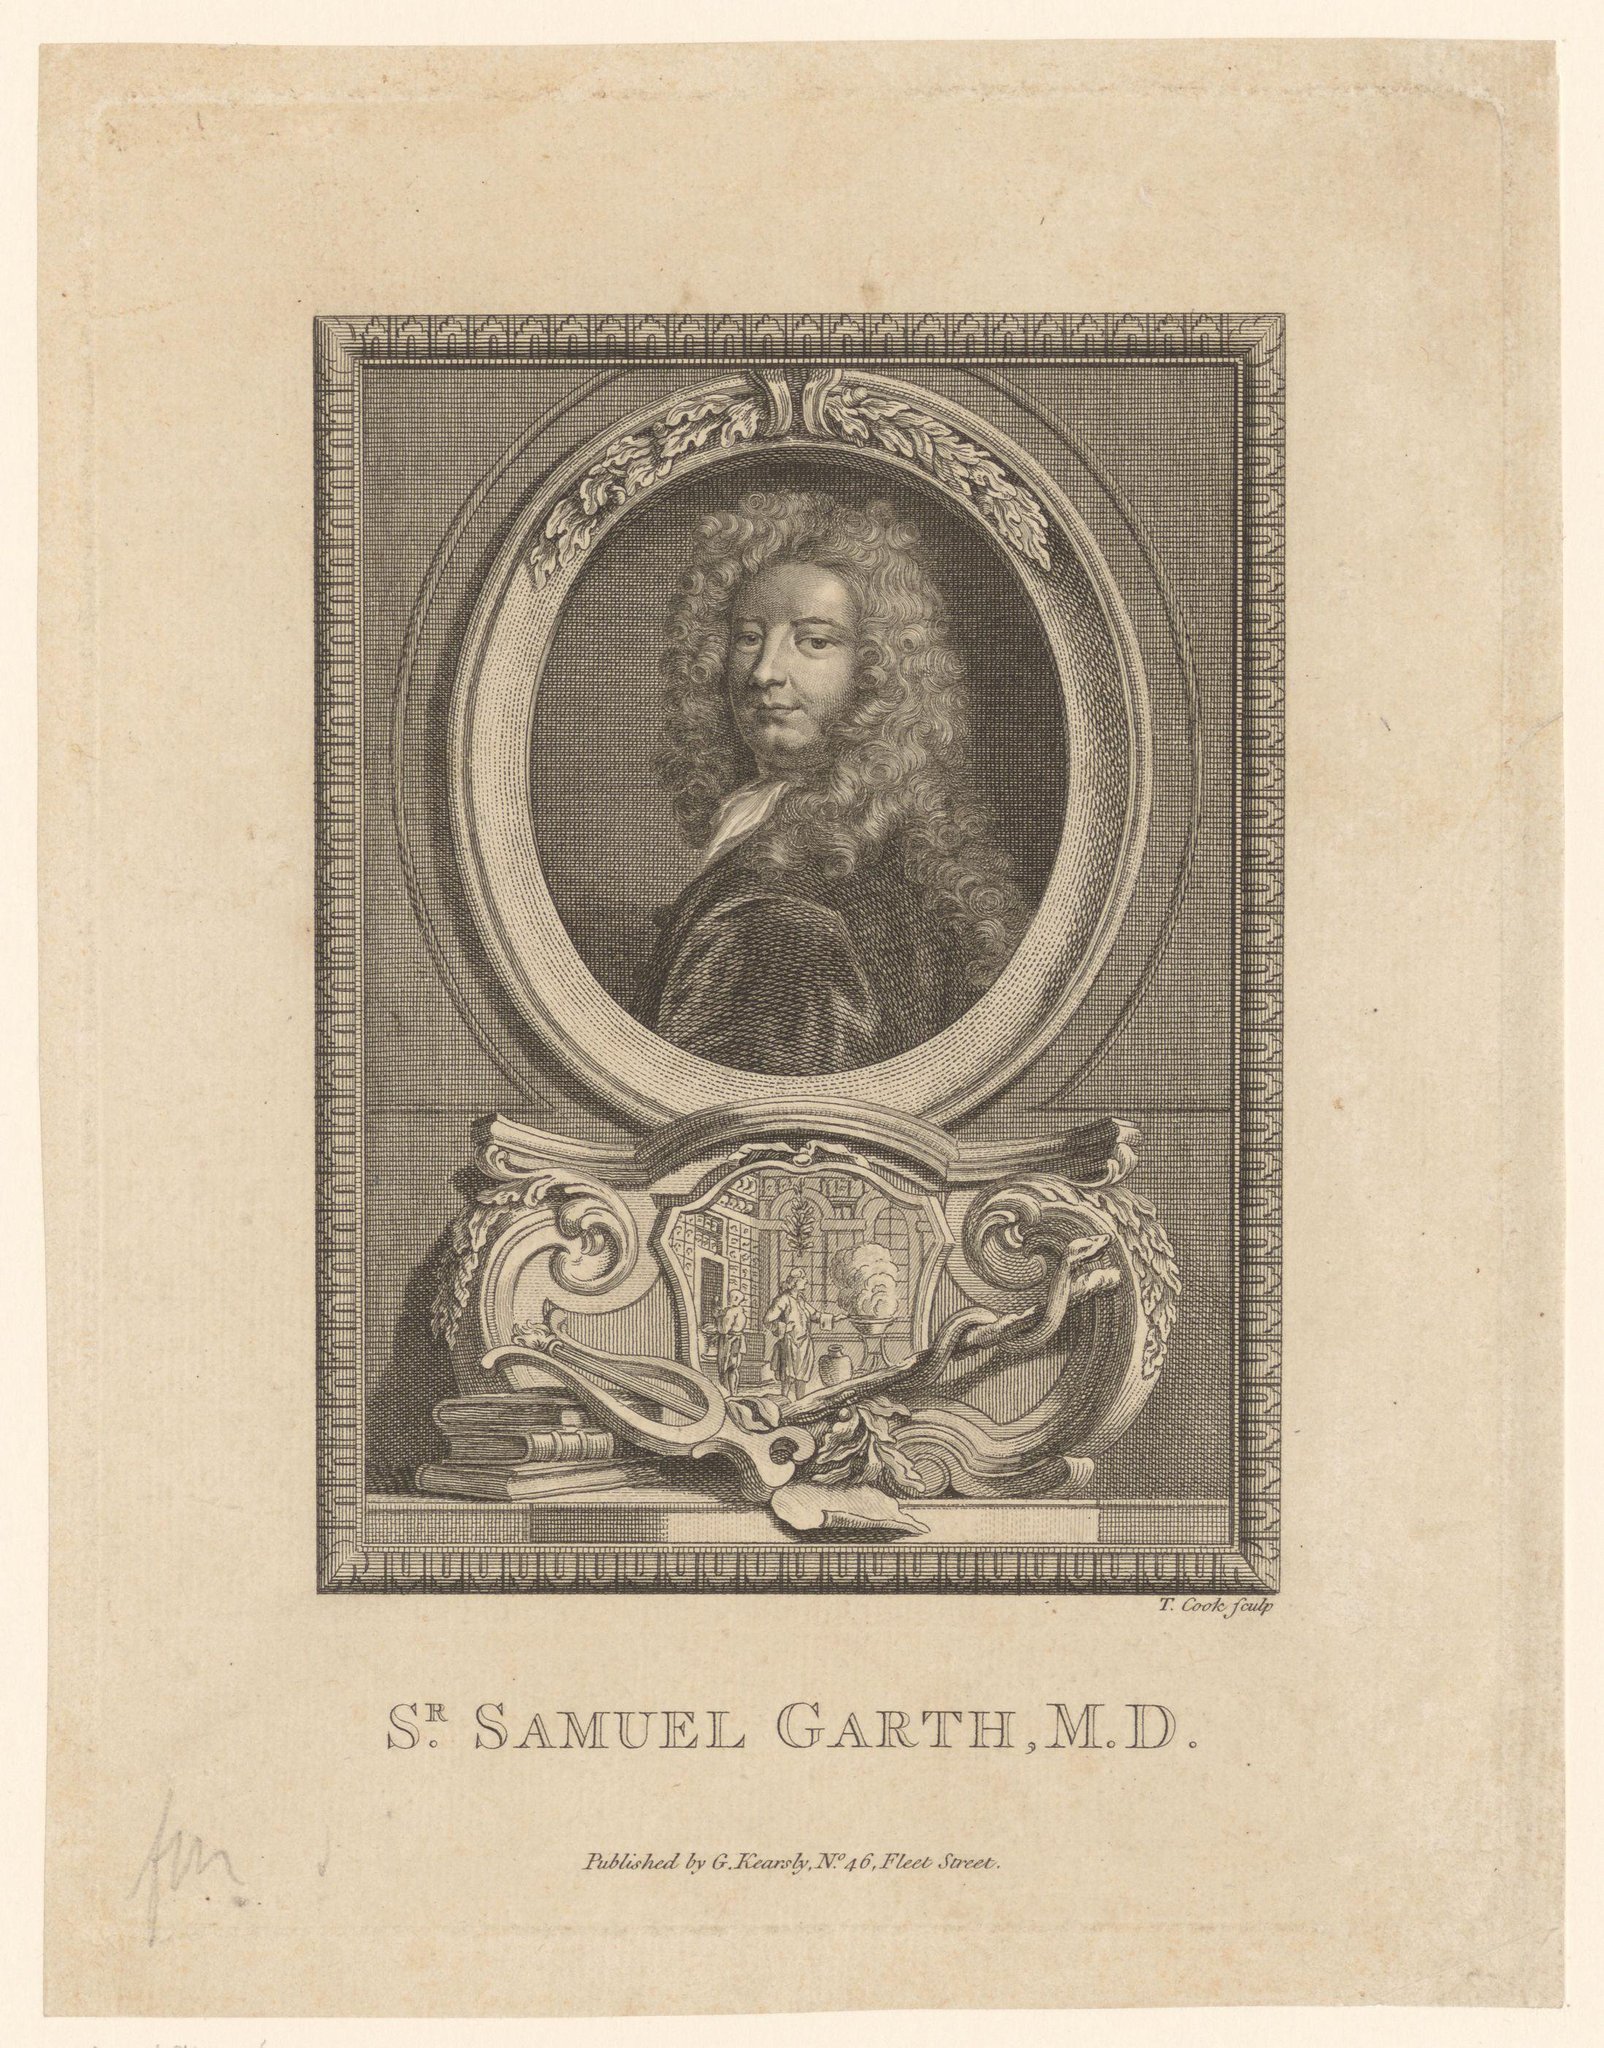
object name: print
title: Portret van Samuel Garth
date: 1773-1790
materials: paper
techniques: engraving, etching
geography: london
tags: london, historical persons, writer, poet, author, physician, doctor (+ portrait of scholar, scientist)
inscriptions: collector's mark: Lugt 2228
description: In een voorstelling onder het medaillon staat een man bij een vuurpot waar rook uit komt. Daarvoor liggen een lier en een esculaap.